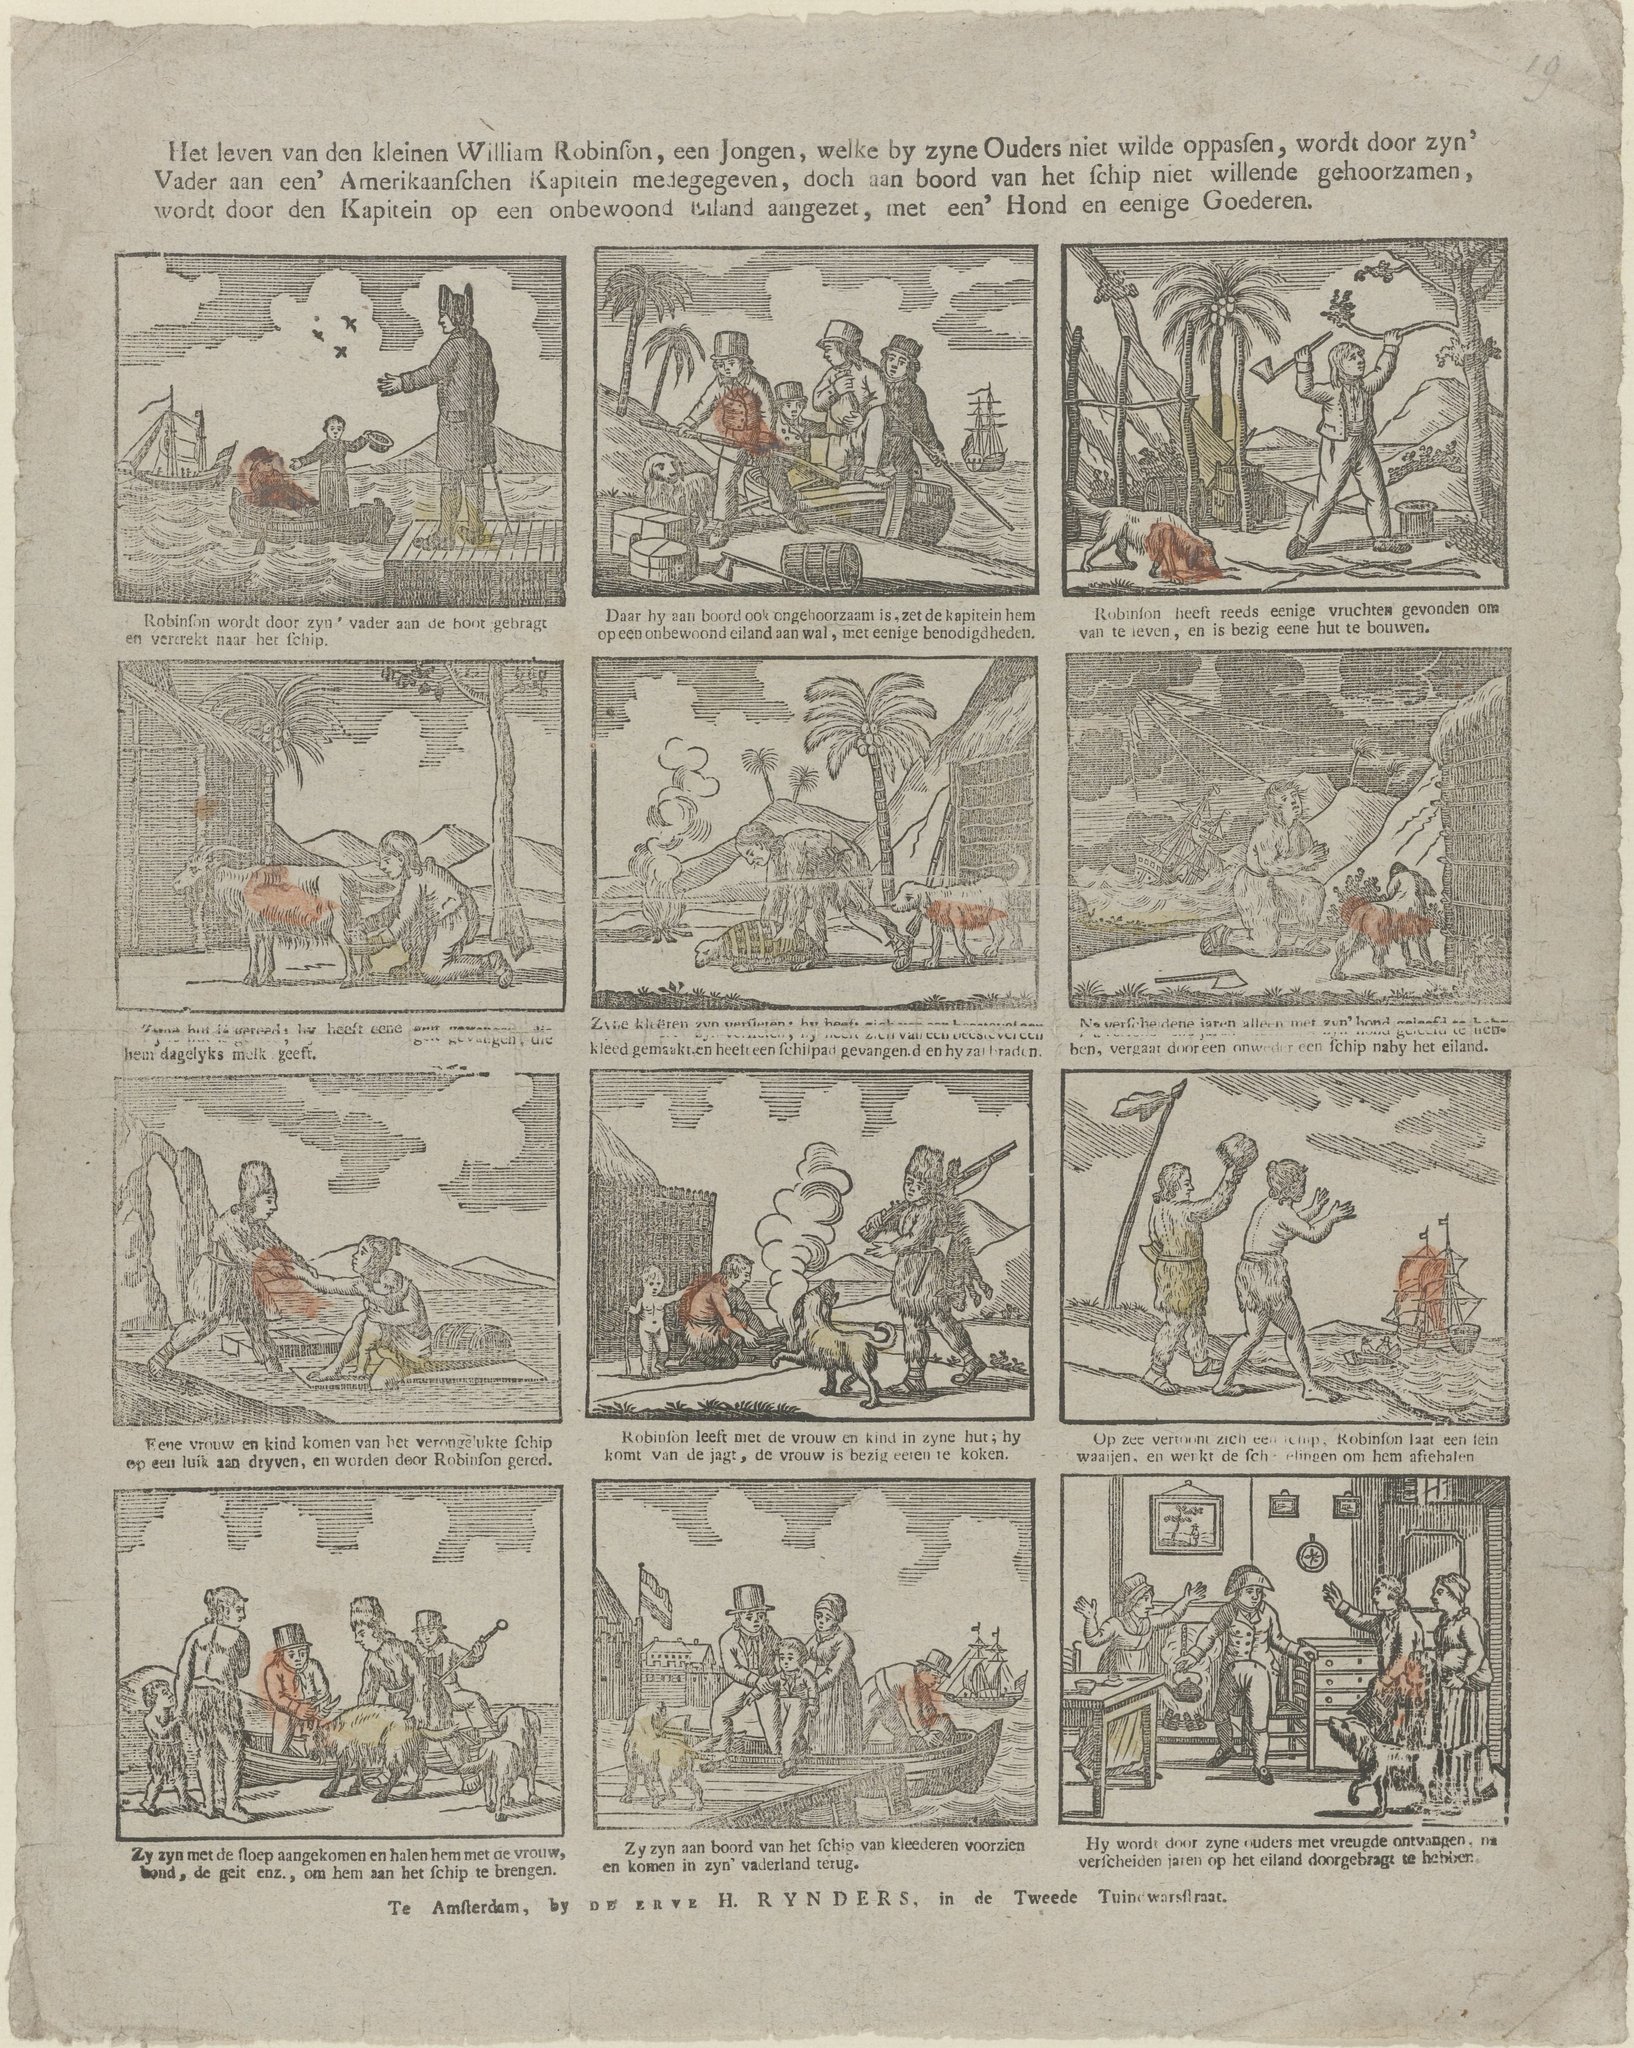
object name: popular print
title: Het leven van den kleinen William Robinson, een jongen, welke by zyne ouders niet wilde oppassen [(...)]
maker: Anonymous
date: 1831-1854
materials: paper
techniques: colour, letterpress printing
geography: netherlands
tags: island, tales and fairy tales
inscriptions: collector's mark: Lugt 2760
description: Blad met 12 voorstellingen over William Robinson die op een onbewoond eiland wordt achtergelaten. Onder elke afbeelding een onderschrift.